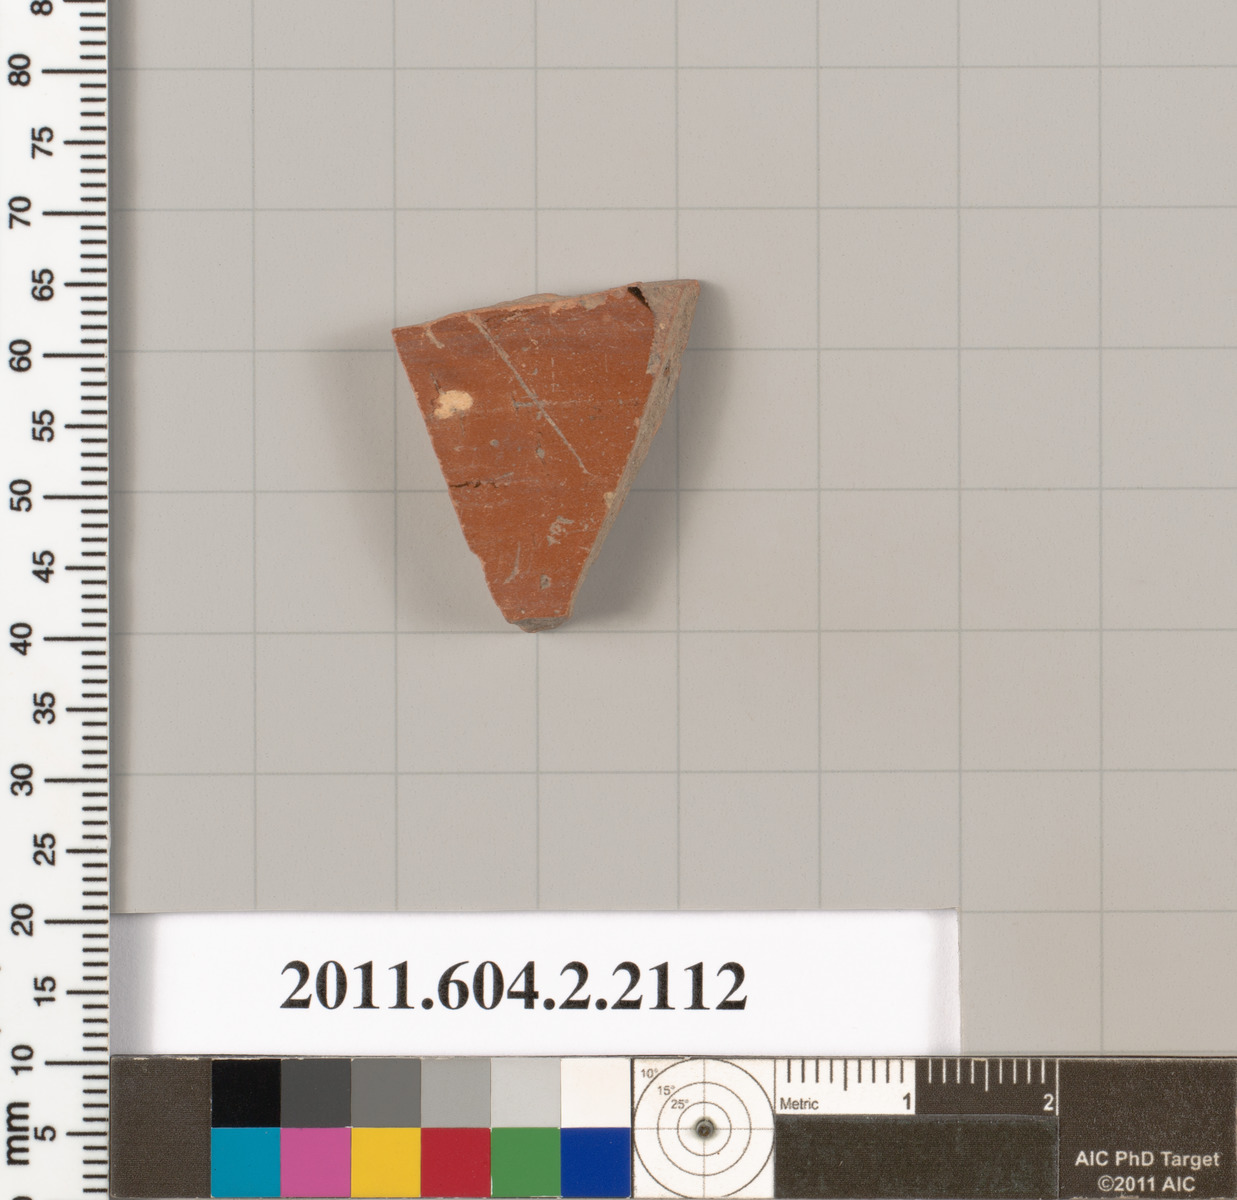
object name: pot fragment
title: Terracotta fragment of a pot; glazed on the inside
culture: greek, attic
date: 500-401 BCE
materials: terracotta